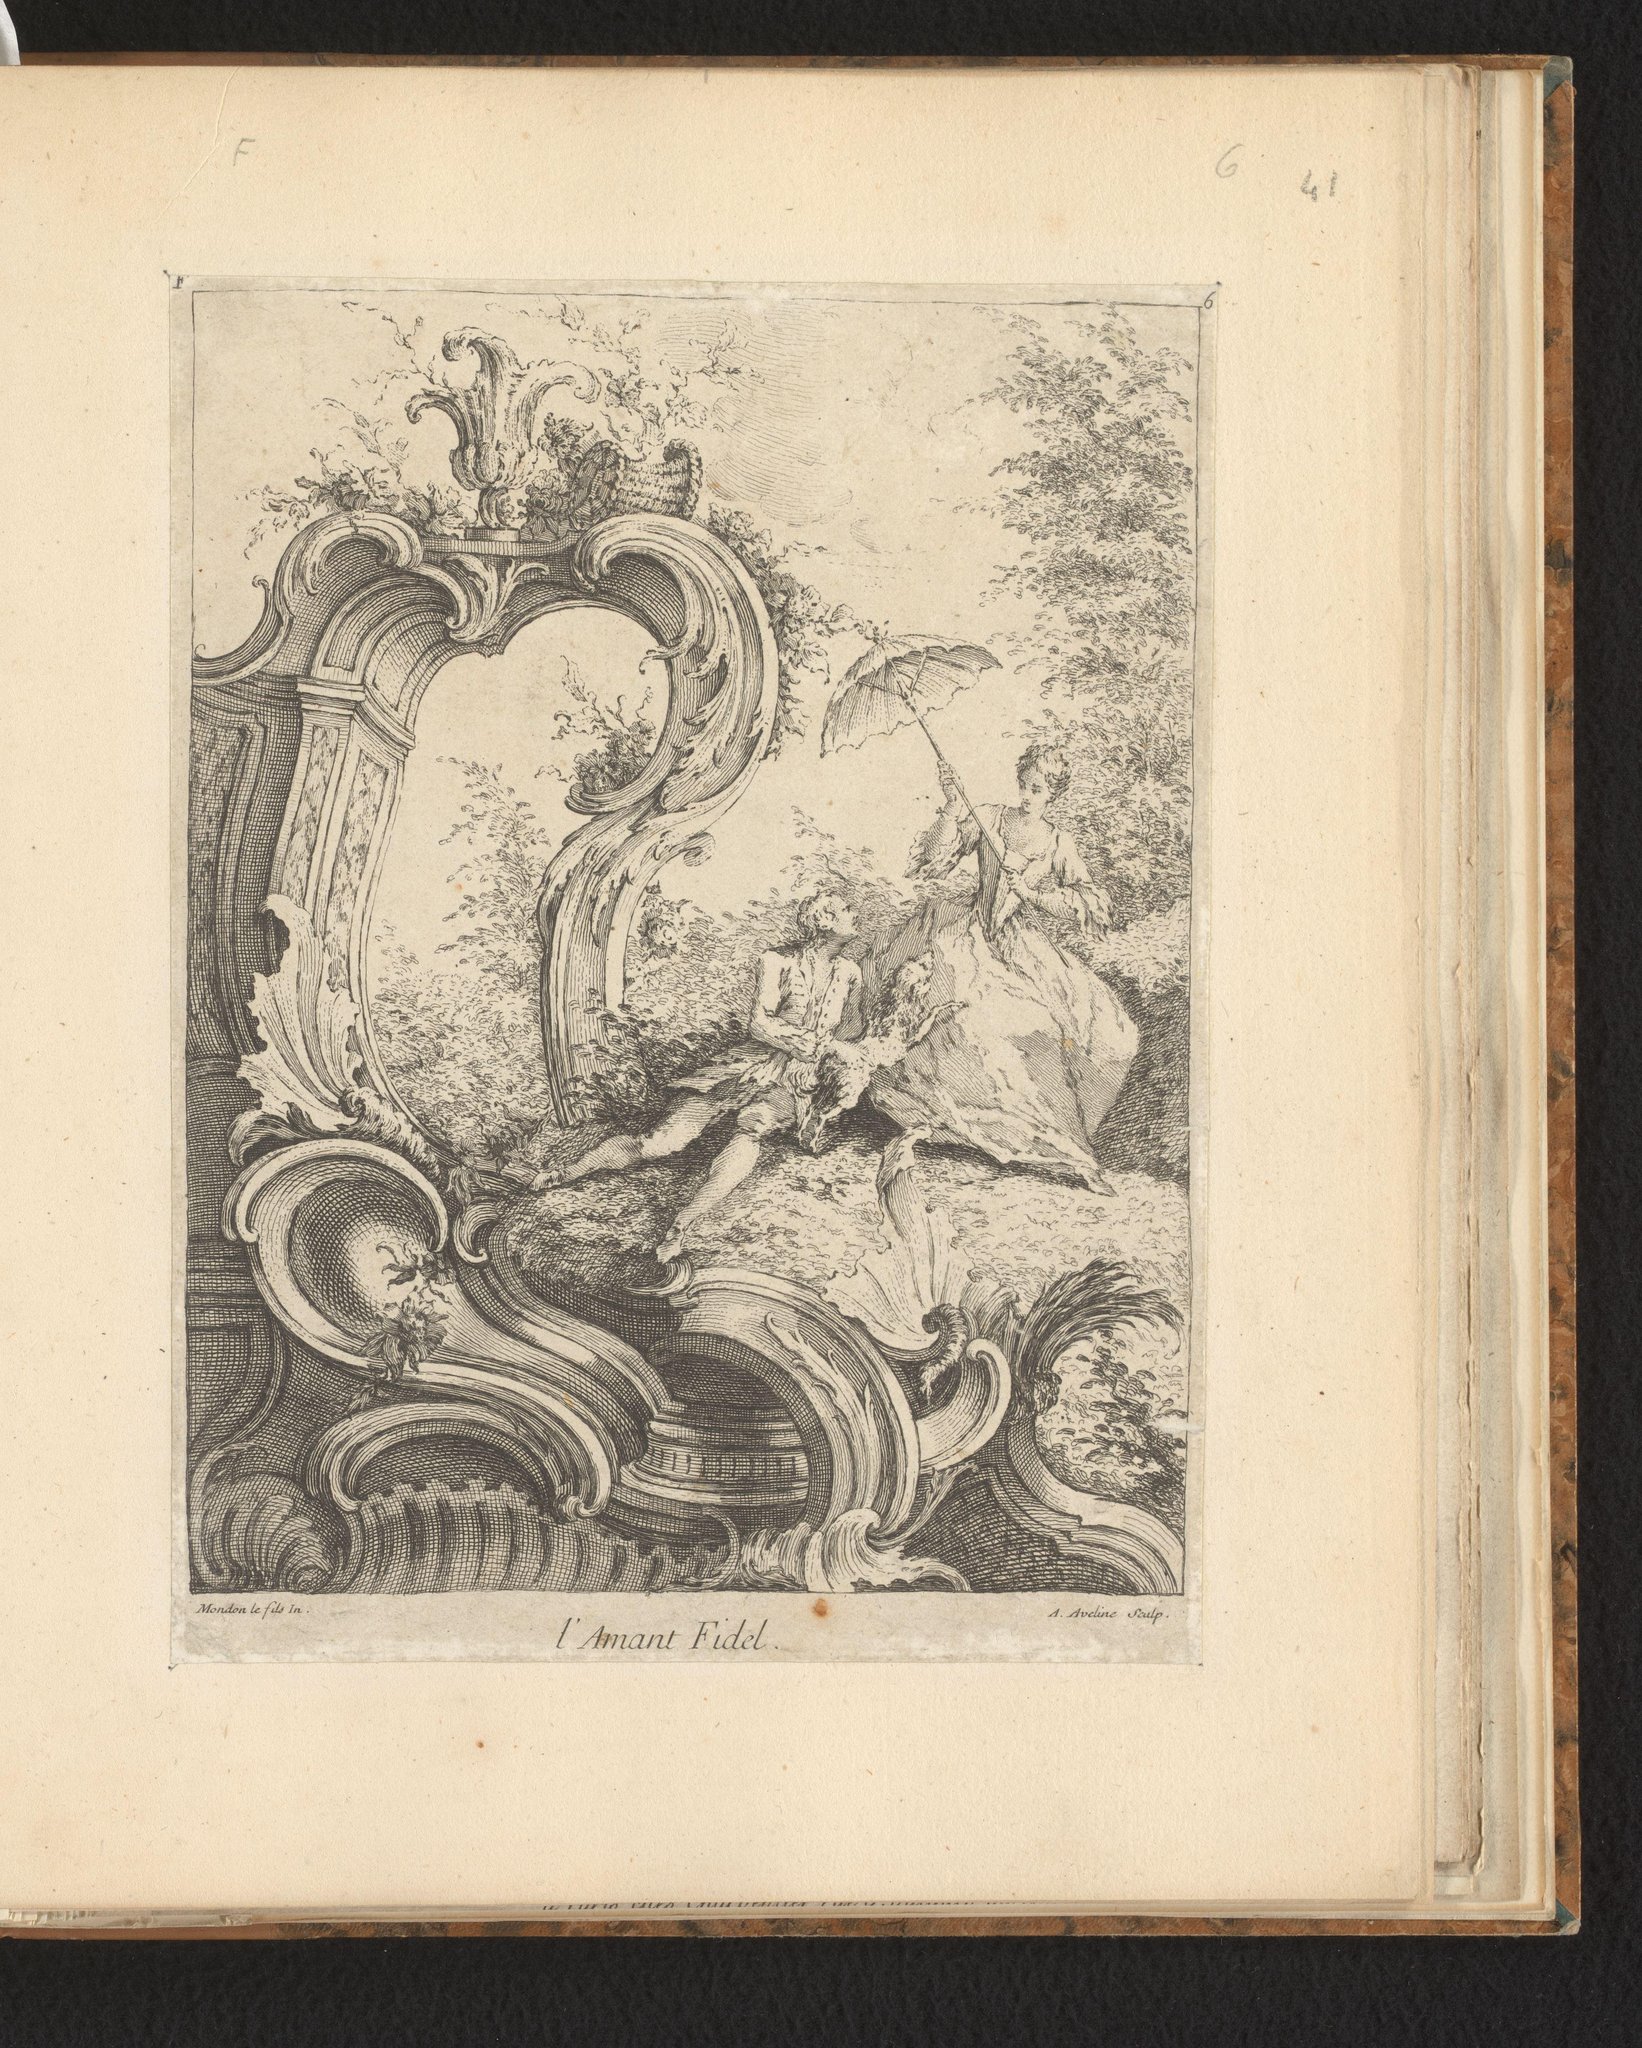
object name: album leaf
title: Sixieme Livre de Formes Rocailles et Cartels ornés de Figures Françoises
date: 1736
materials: paper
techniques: engraving, etching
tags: rocaille ornament, lovers; courting, flirting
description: Deze serie is linksboven genummerd met een letter F. Prent maakt deel uit van een album.